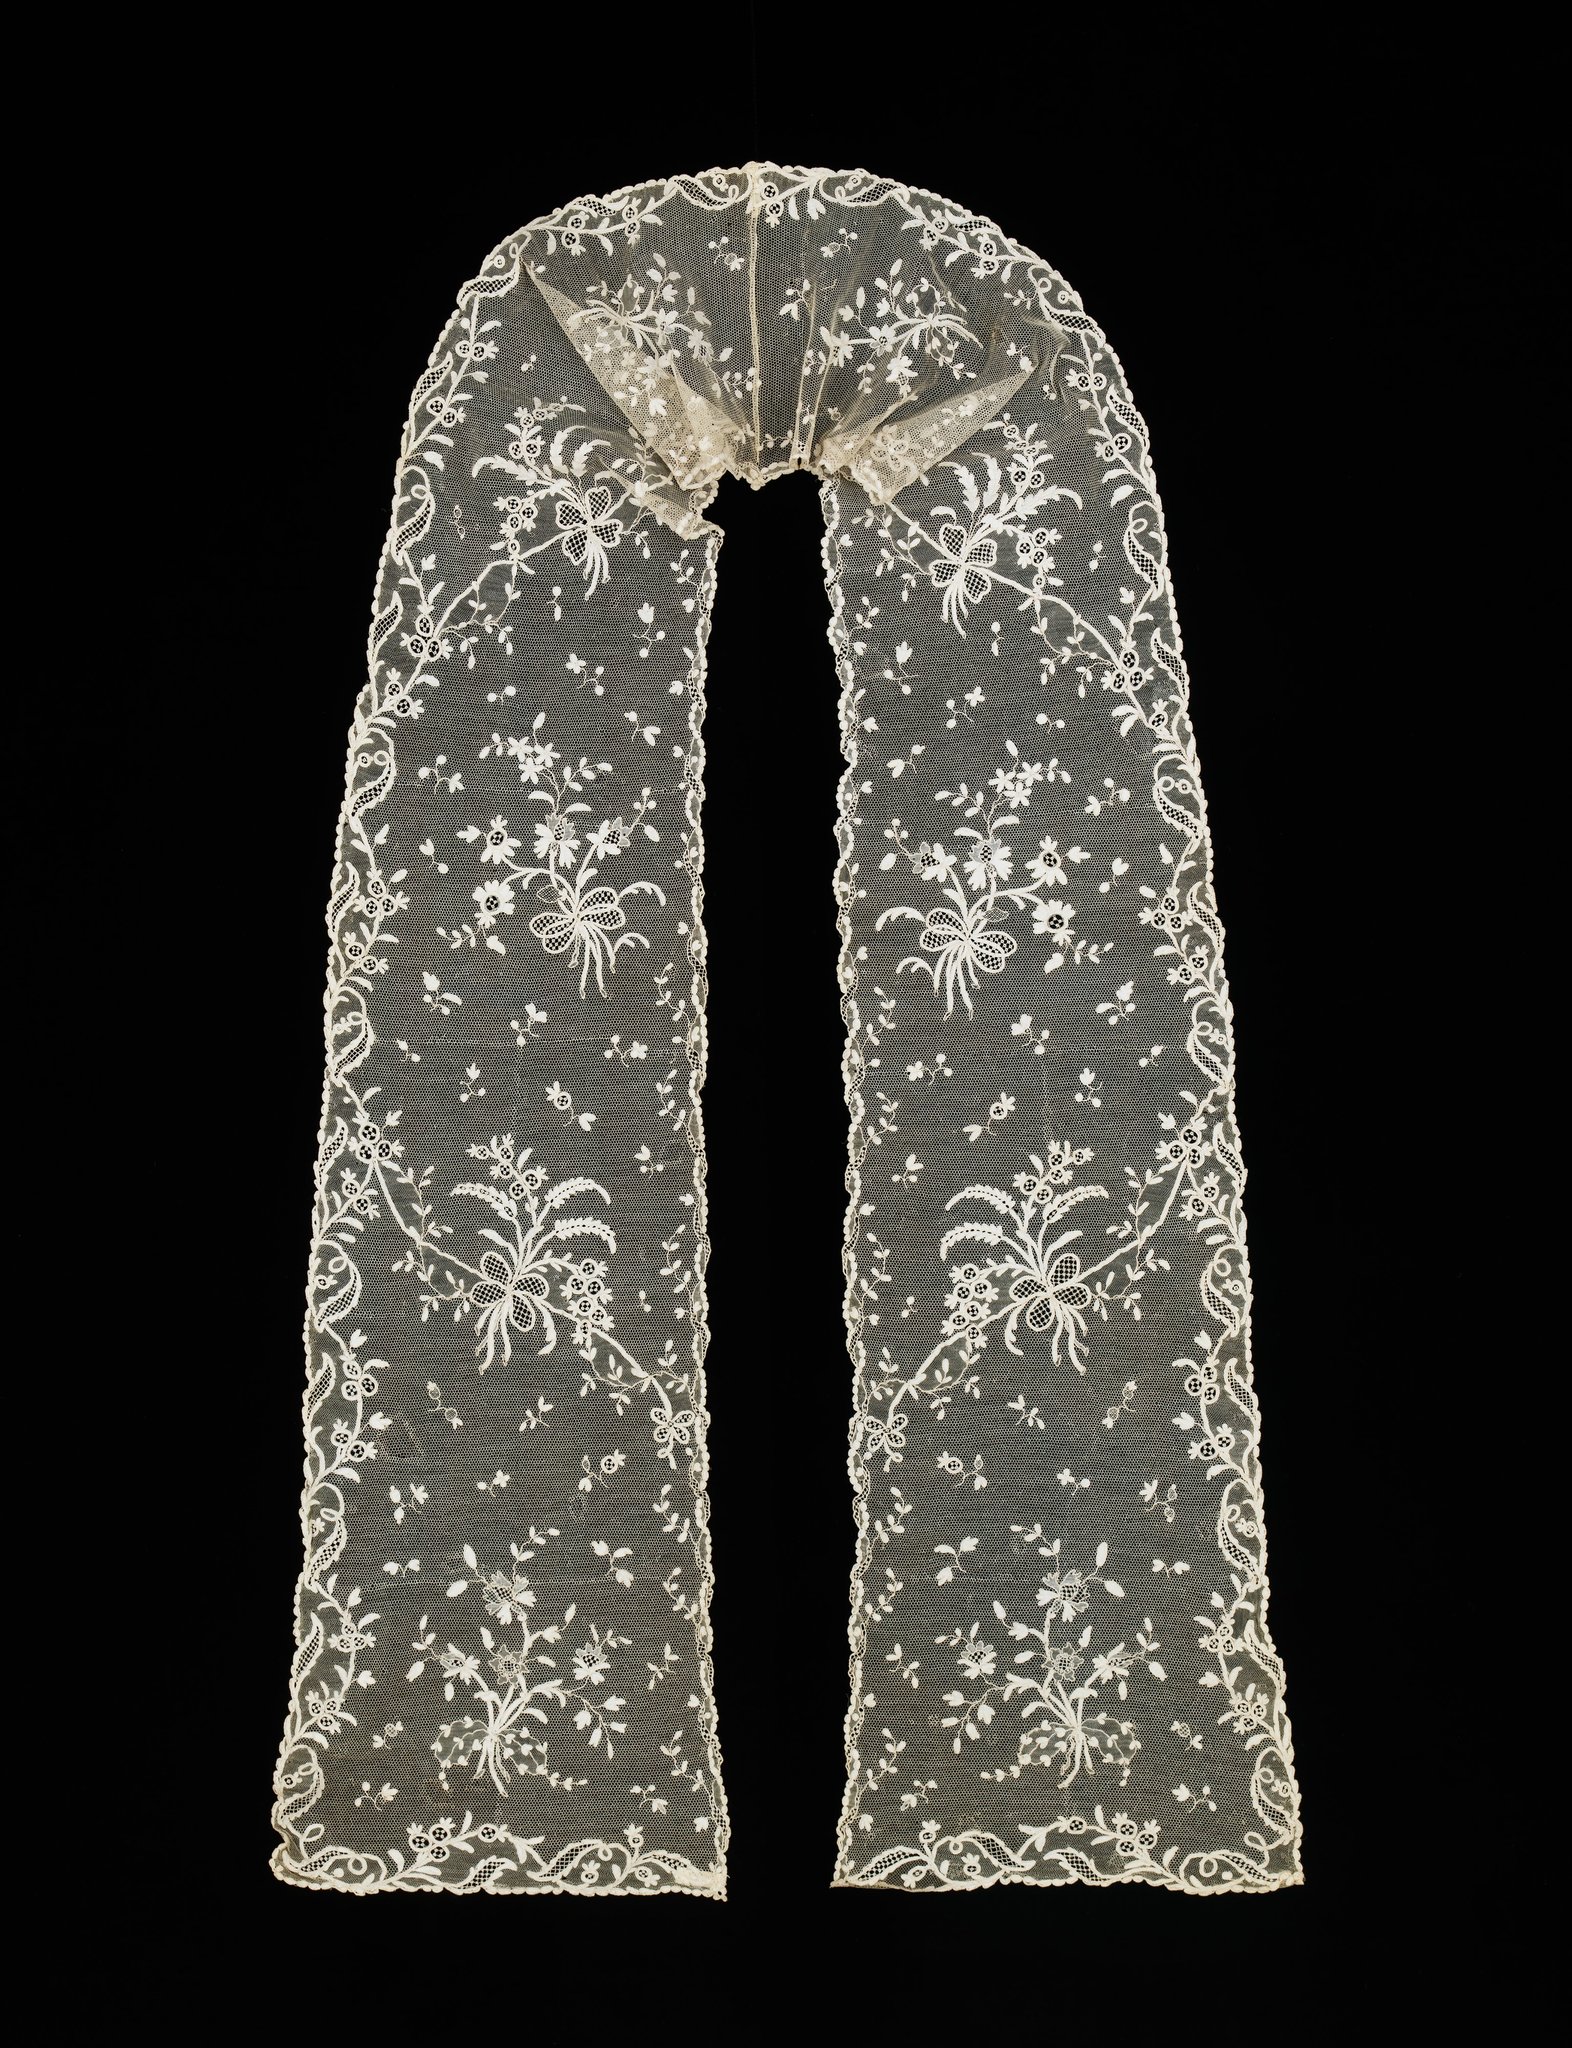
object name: scarf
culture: european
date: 1801-1900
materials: linen